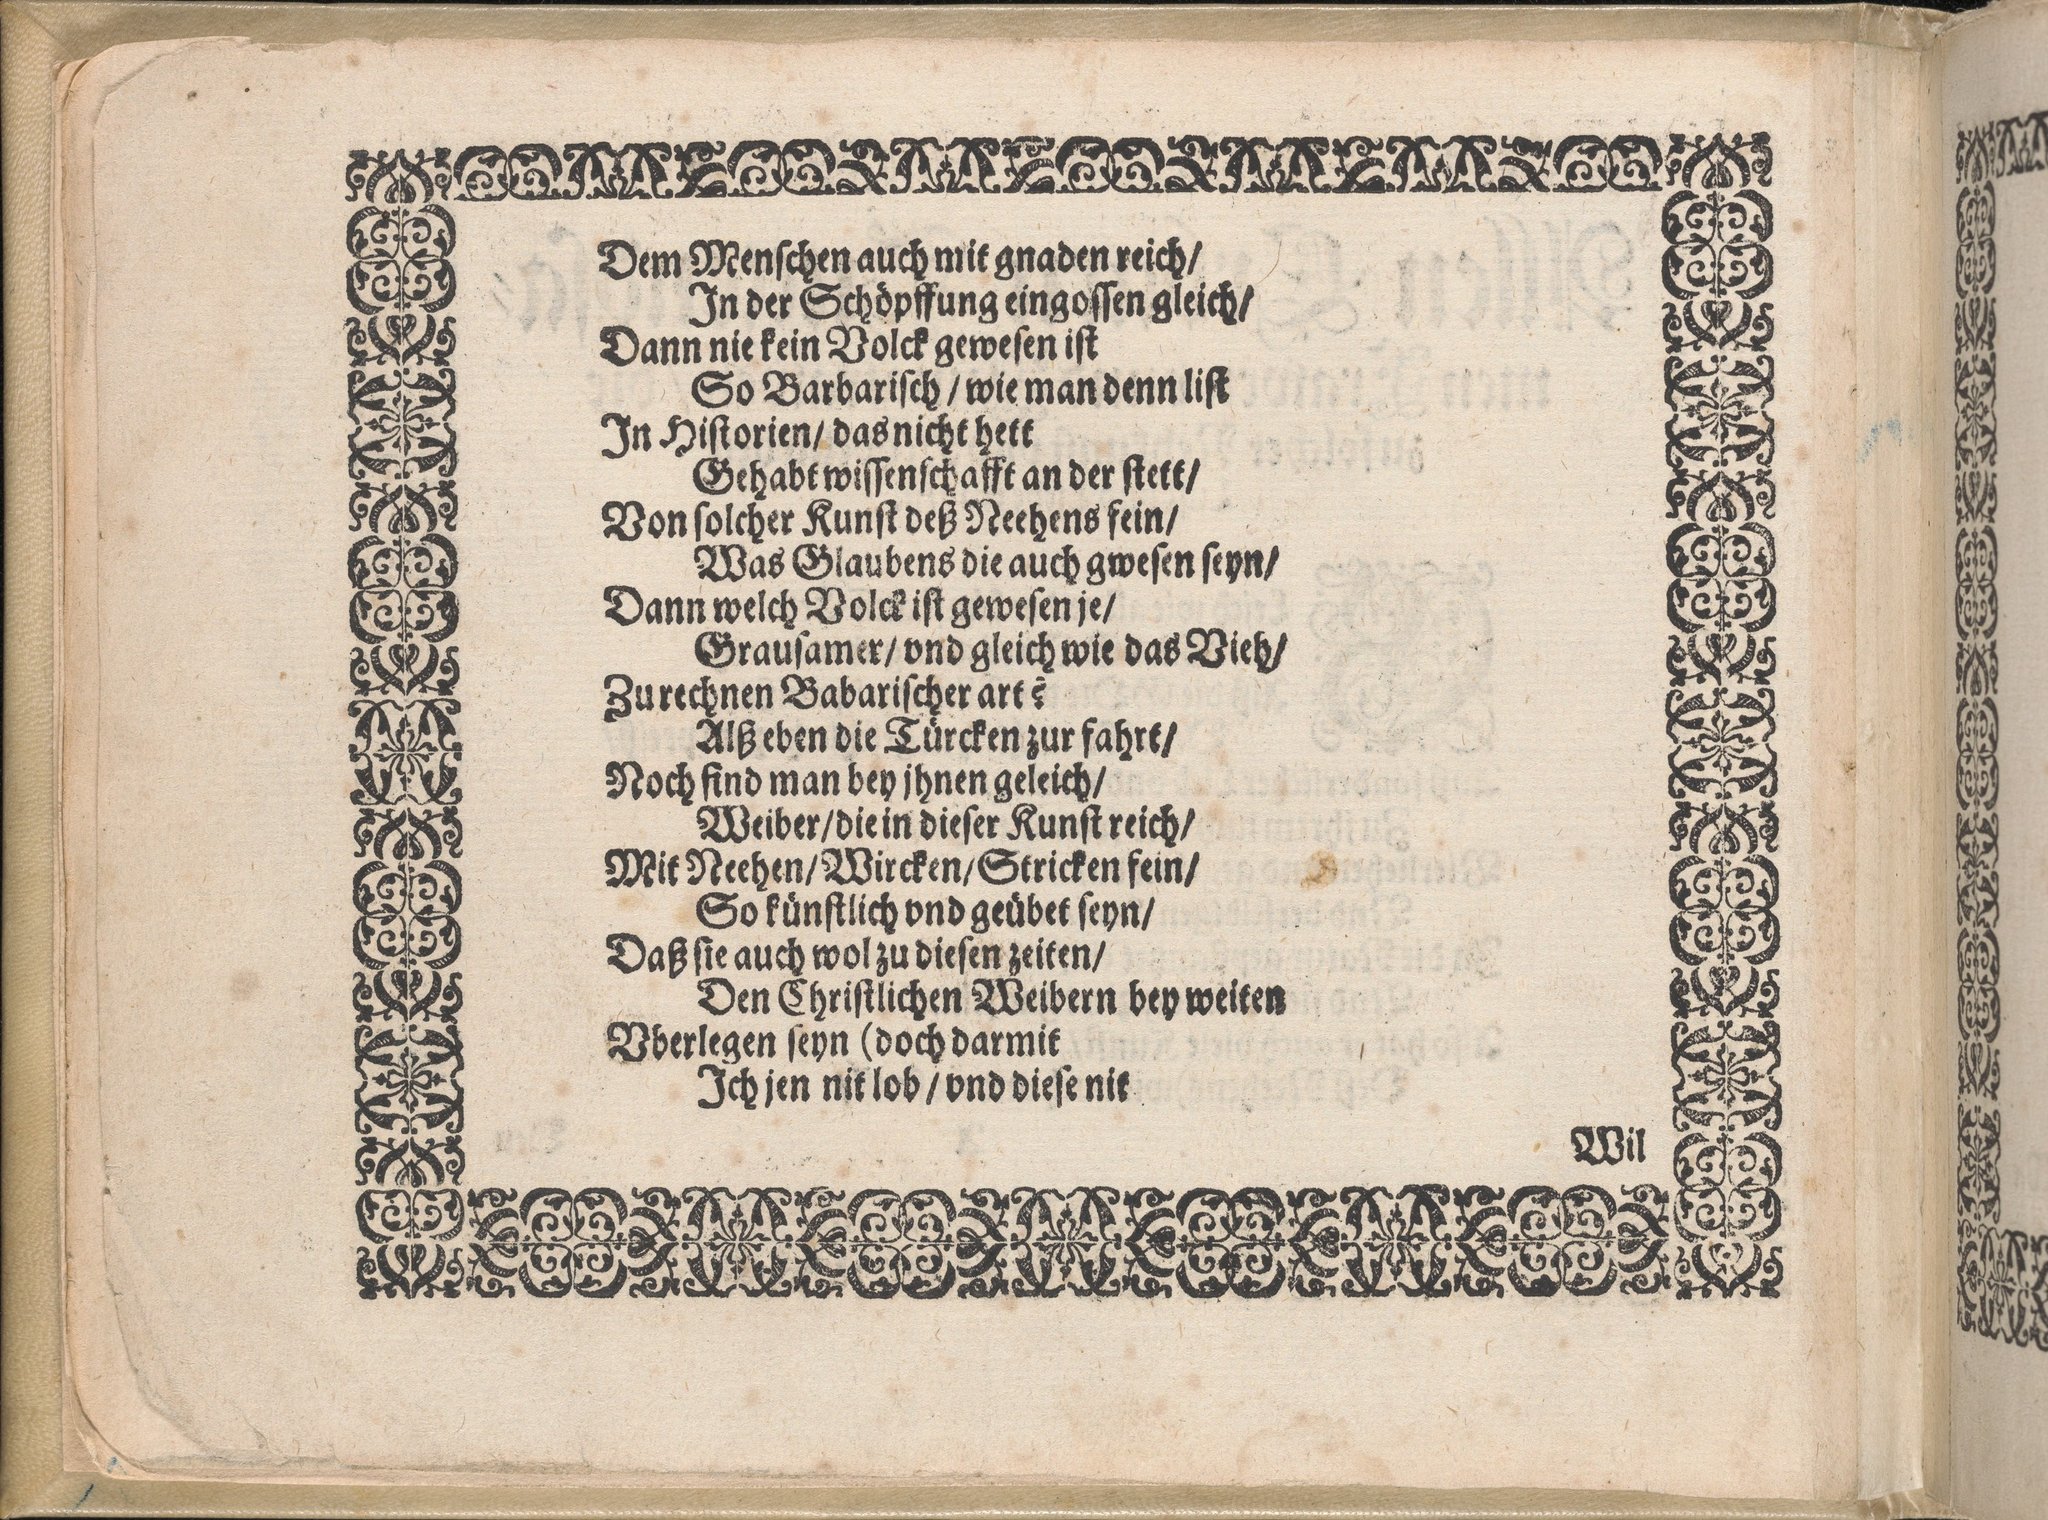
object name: book print ornament architecture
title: Schön Neues Modelbuch (Page 2 verso)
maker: johann sibmacher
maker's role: designer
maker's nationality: german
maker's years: 1590-1611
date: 1597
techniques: woodcut